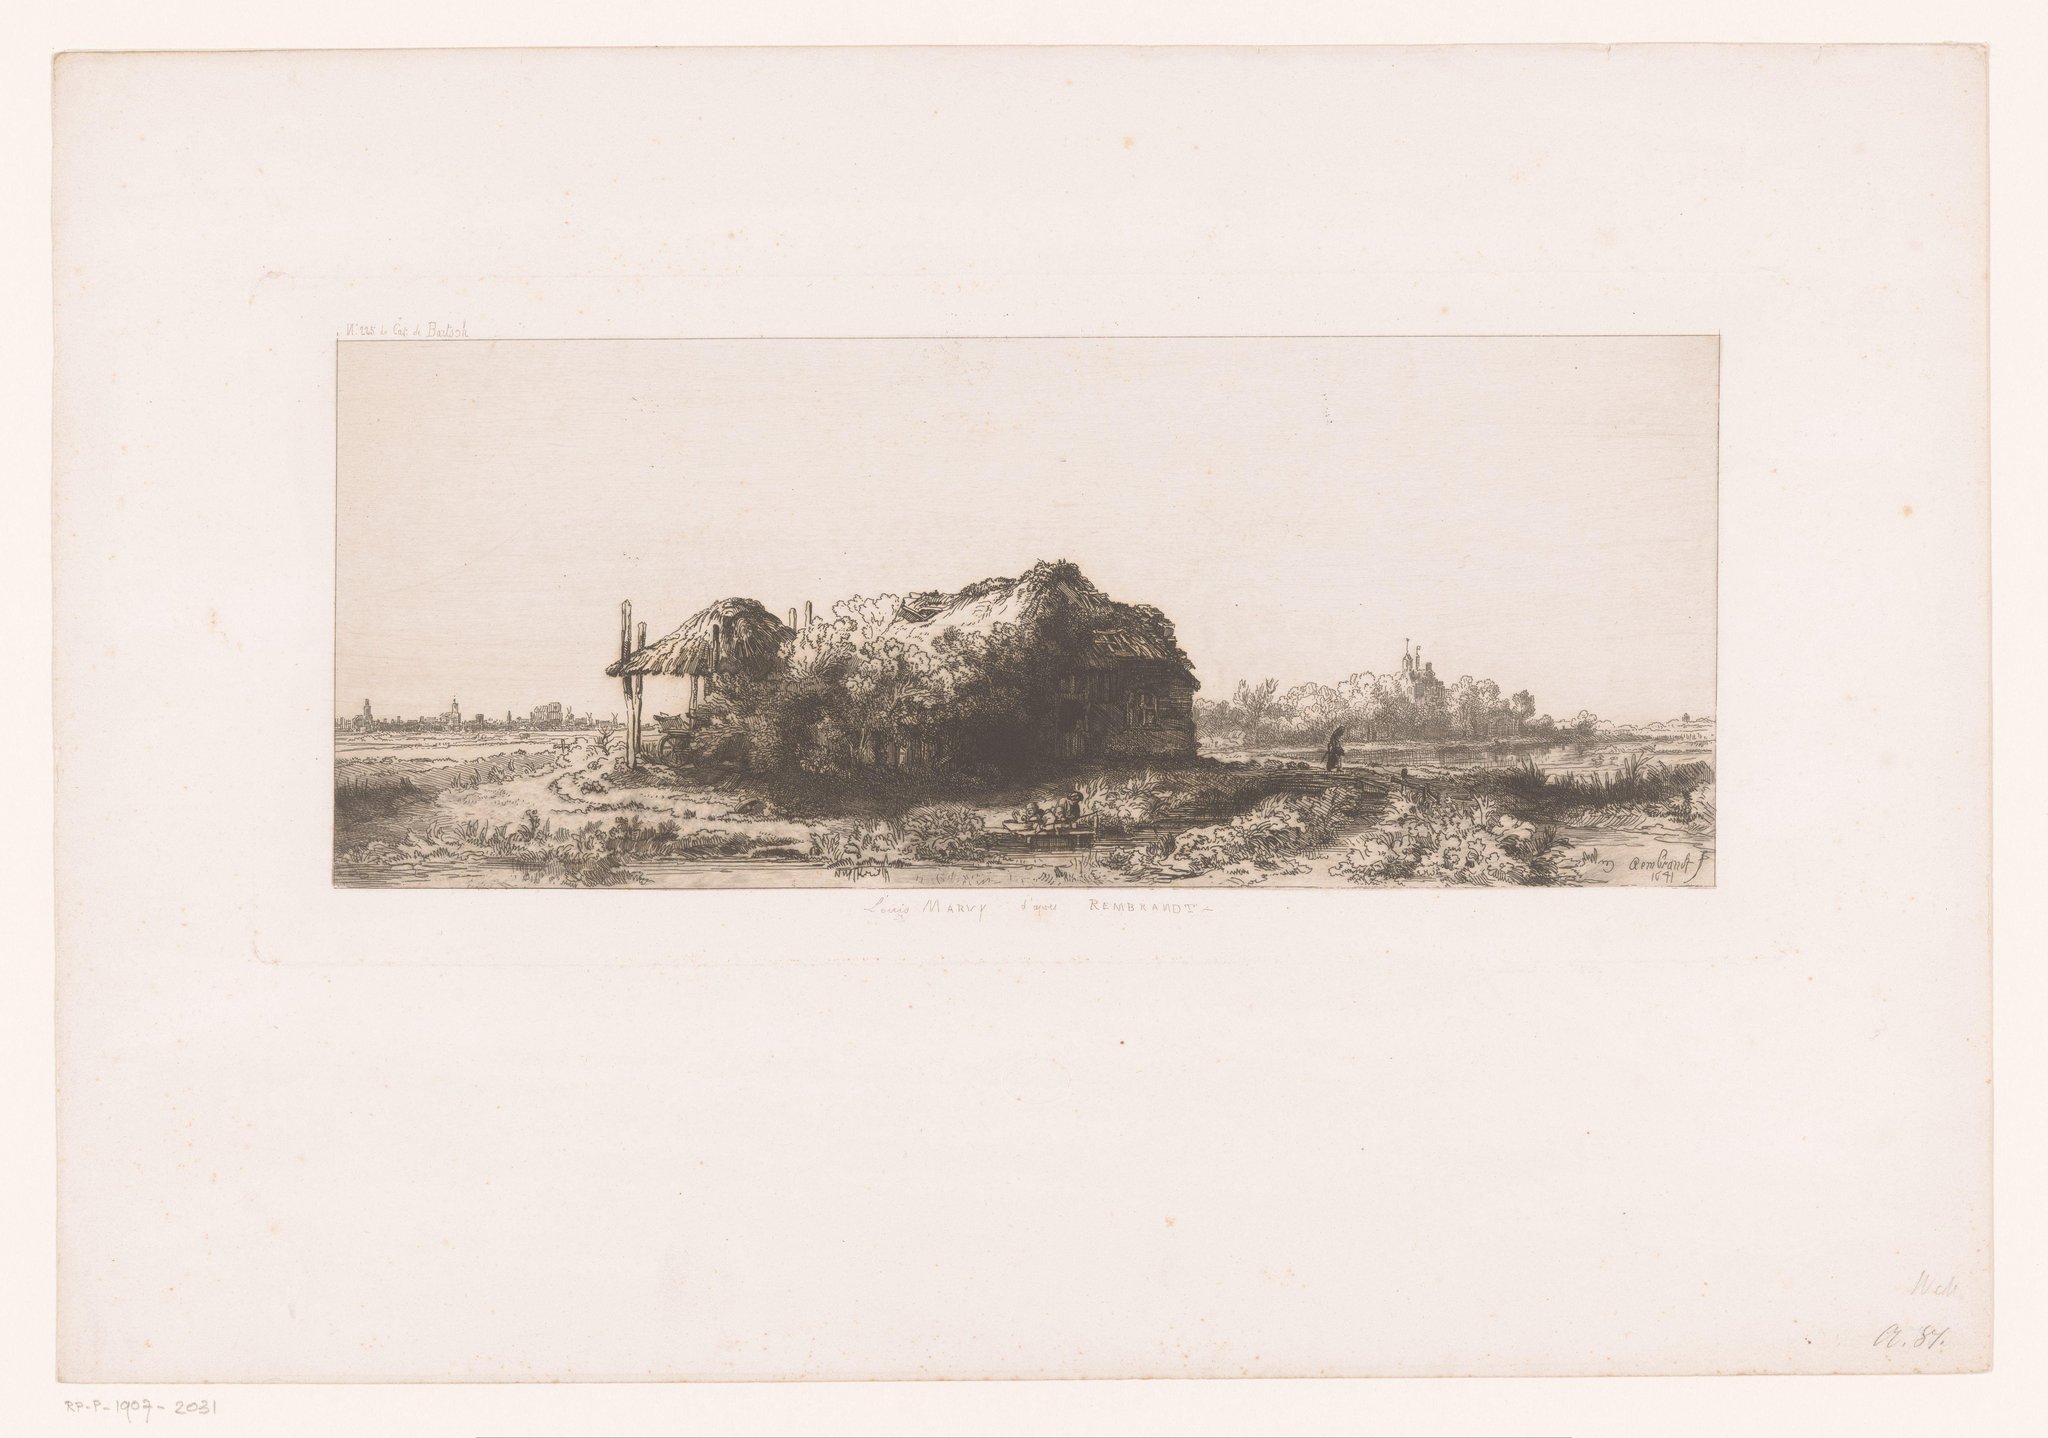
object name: print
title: Cottages and a hay barn on the Diemerdijk with a flock of sheep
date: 1825-1850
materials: paper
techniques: drypoint, etching, intaglio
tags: landscapes, hay-stack, outskirts of city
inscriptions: check stamp, collector's mark: Lugt 2228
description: Spiegelbeeldige kopie naar de gelijknamige prent van Rembrandt.